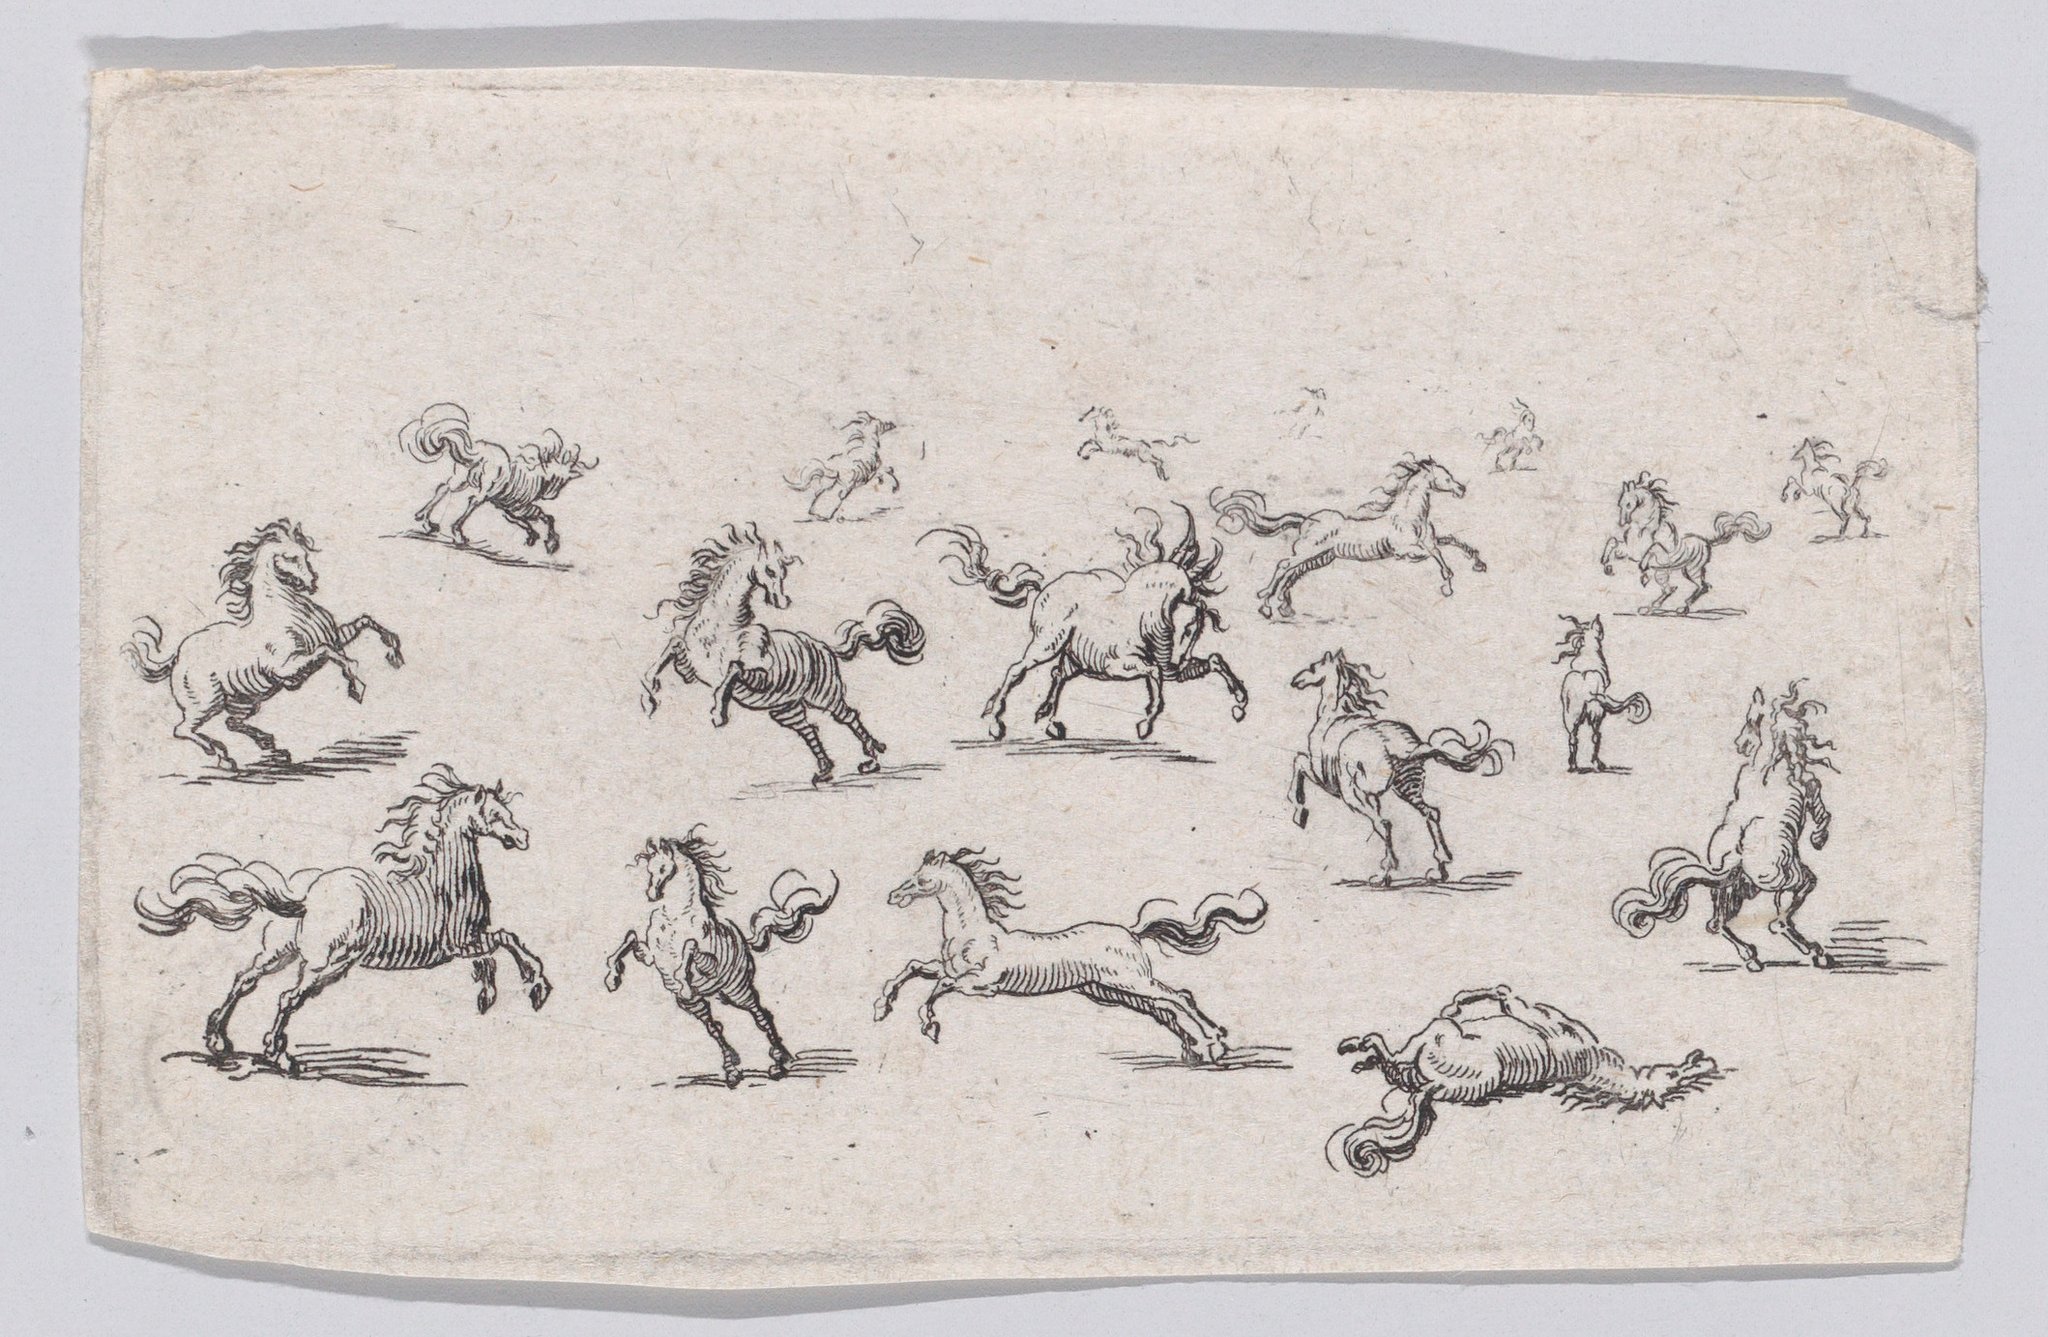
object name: print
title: Reverse Copy of Chevaux Courant en Liberté (Horses Running Freely), from "Les Caprices"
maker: Anonymous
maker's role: artist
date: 1601-1700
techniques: etching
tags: horses